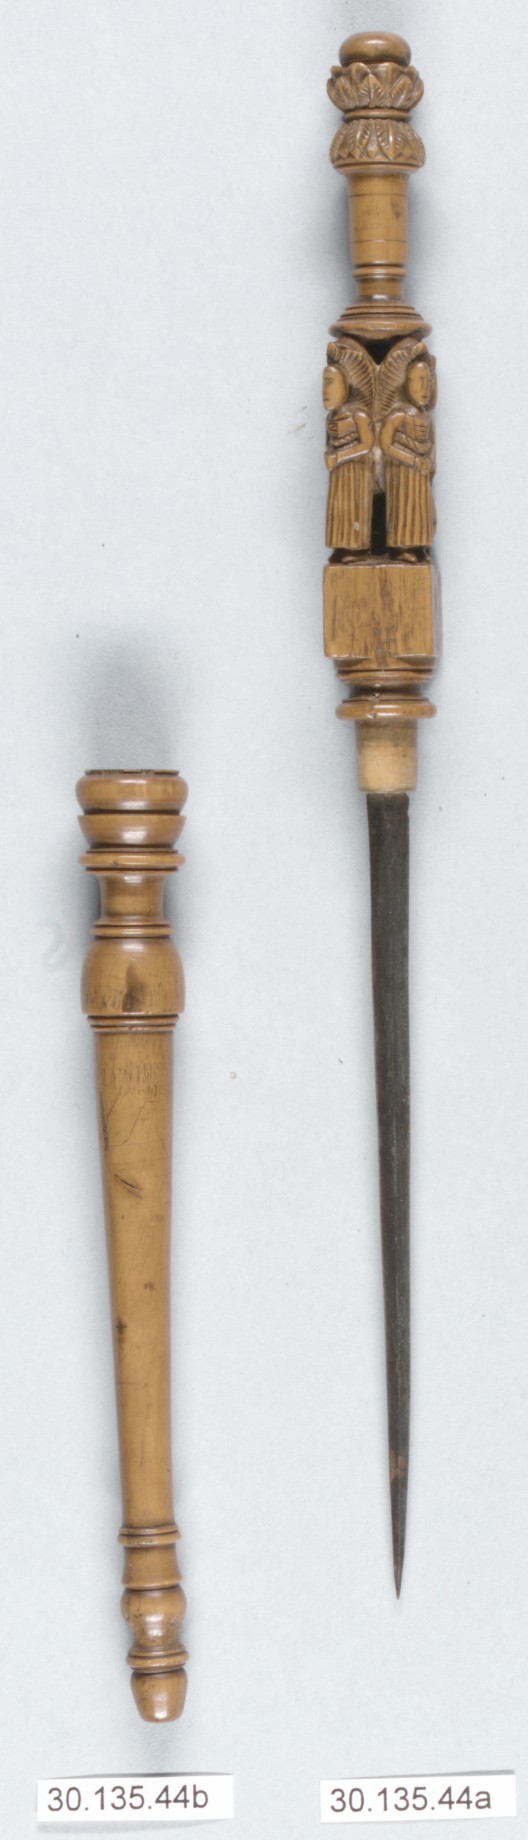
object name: embroidery punch with sheath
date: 1701-1800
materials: wood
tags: human figures